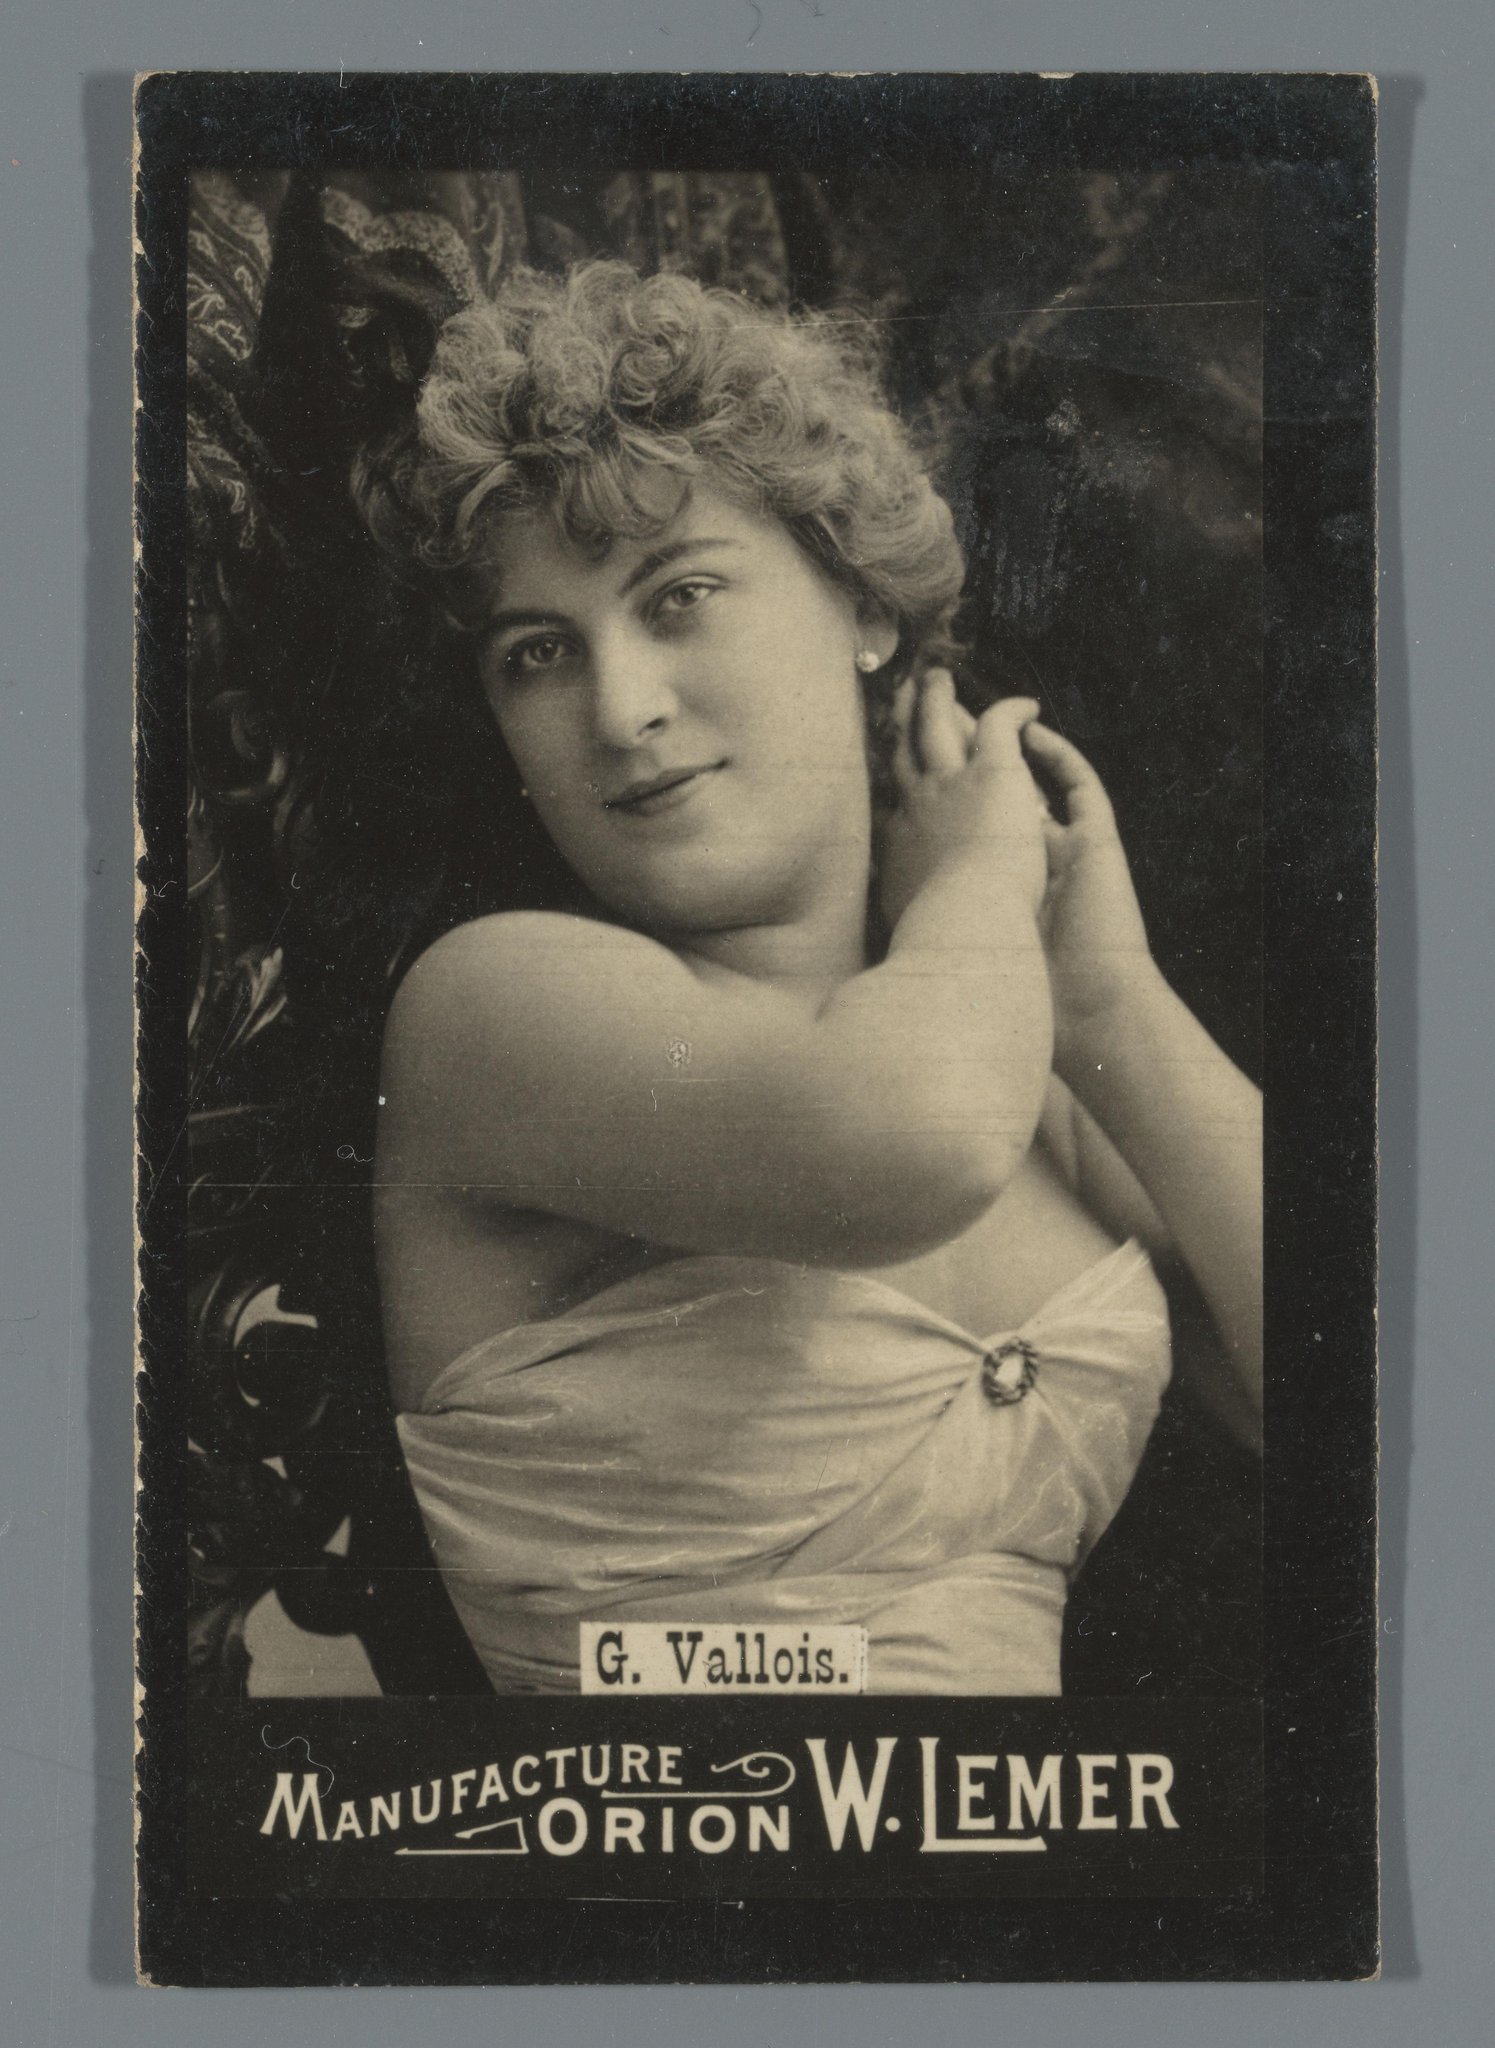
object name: photograph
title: G. Vallois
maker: Anonymous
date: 1895-1910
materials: paper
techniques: gelatin silver print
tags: adult woman, anonymous historical person portrayed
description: Dergelijke foto's stonden bekend als 'zwartjes'. Men verkreeg ze bij aanschaf van bepaalde merken thee, cacao, sigaretten, beschuit, etc. om te verzamelen. Er waren speciaal voor de 'zwartjes' verzamelalbums in omloop.